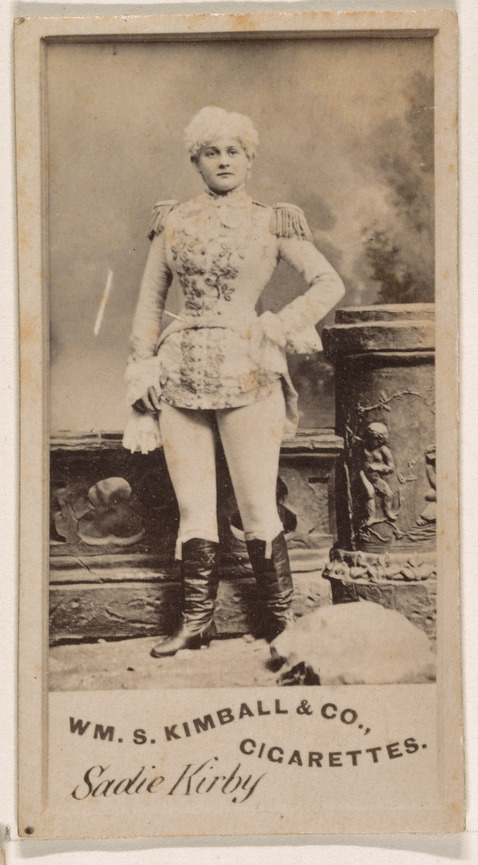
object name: photograph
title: Sadie Kirby, from the Actresses series (N203) issued by Wm. S. Kimball & Co.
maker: william s. kimball & company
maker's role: publisher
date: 1889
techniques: color lithograph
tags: portraits,women,actresses